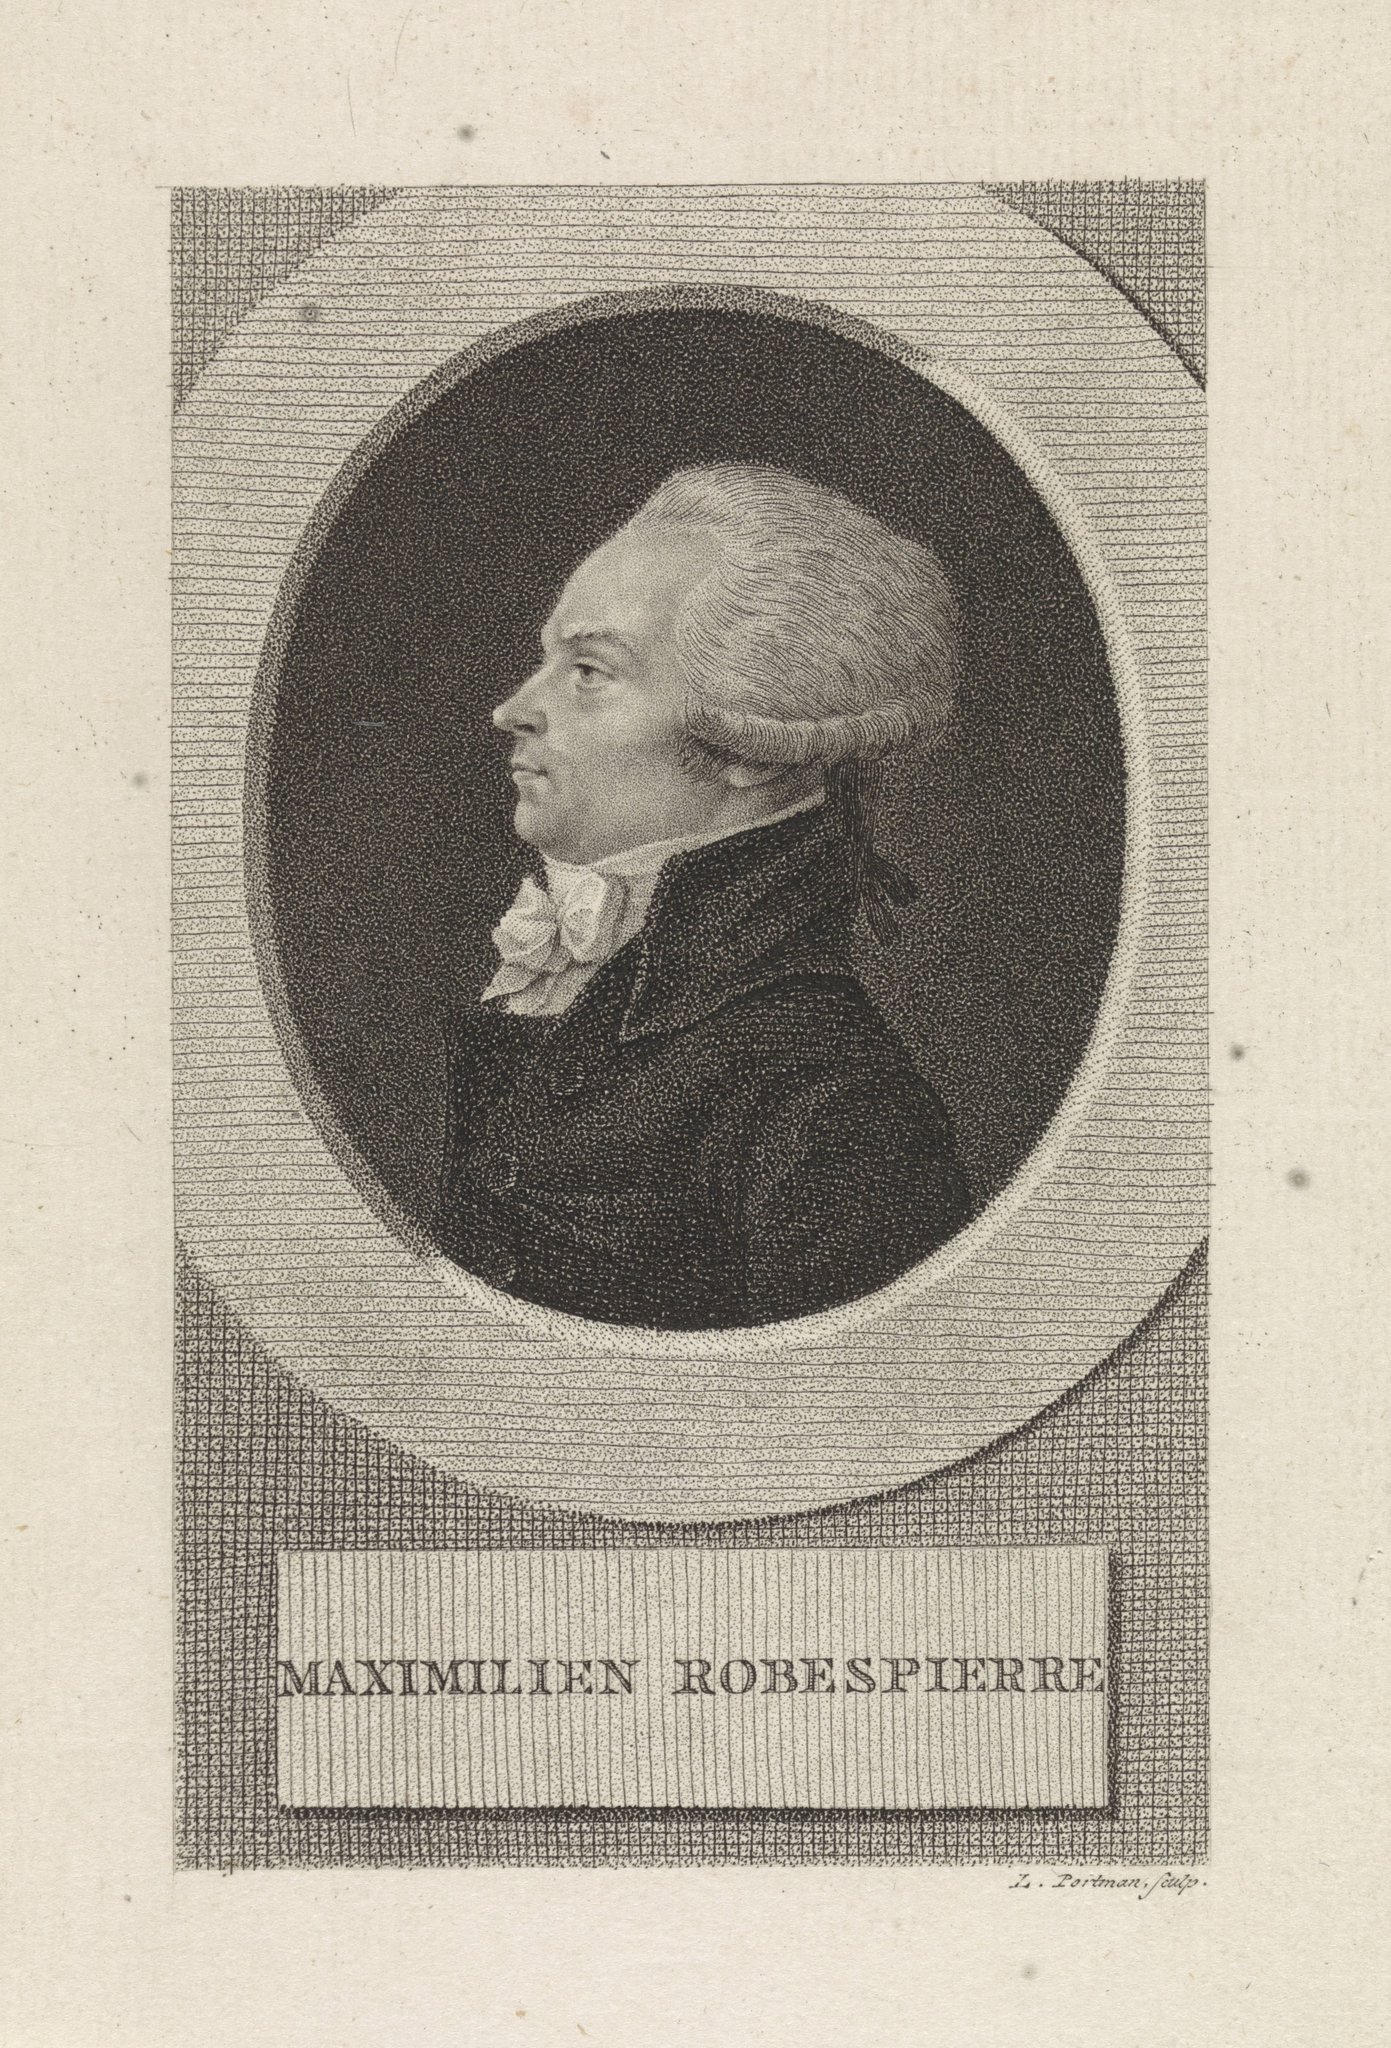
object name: print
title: Portret van de Franse advocaat Maximilien-Marie Isidore de Robespierre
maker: ludwig gottlieb portman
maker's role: print maker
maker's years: 1772-1828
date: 1805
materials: paper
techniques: stippled etching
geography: amsterdam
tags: arras, advocaat, maximilien-marie-isidore de robespierre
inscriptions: collector's mark: Lugt 2228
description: Prent vermoedelijk ook gebruikt als illustratie in: Tafereelen van de staatsomwenteling in Frankrijk, deel 20. Amsterdam: Johannes Allart, 1805.